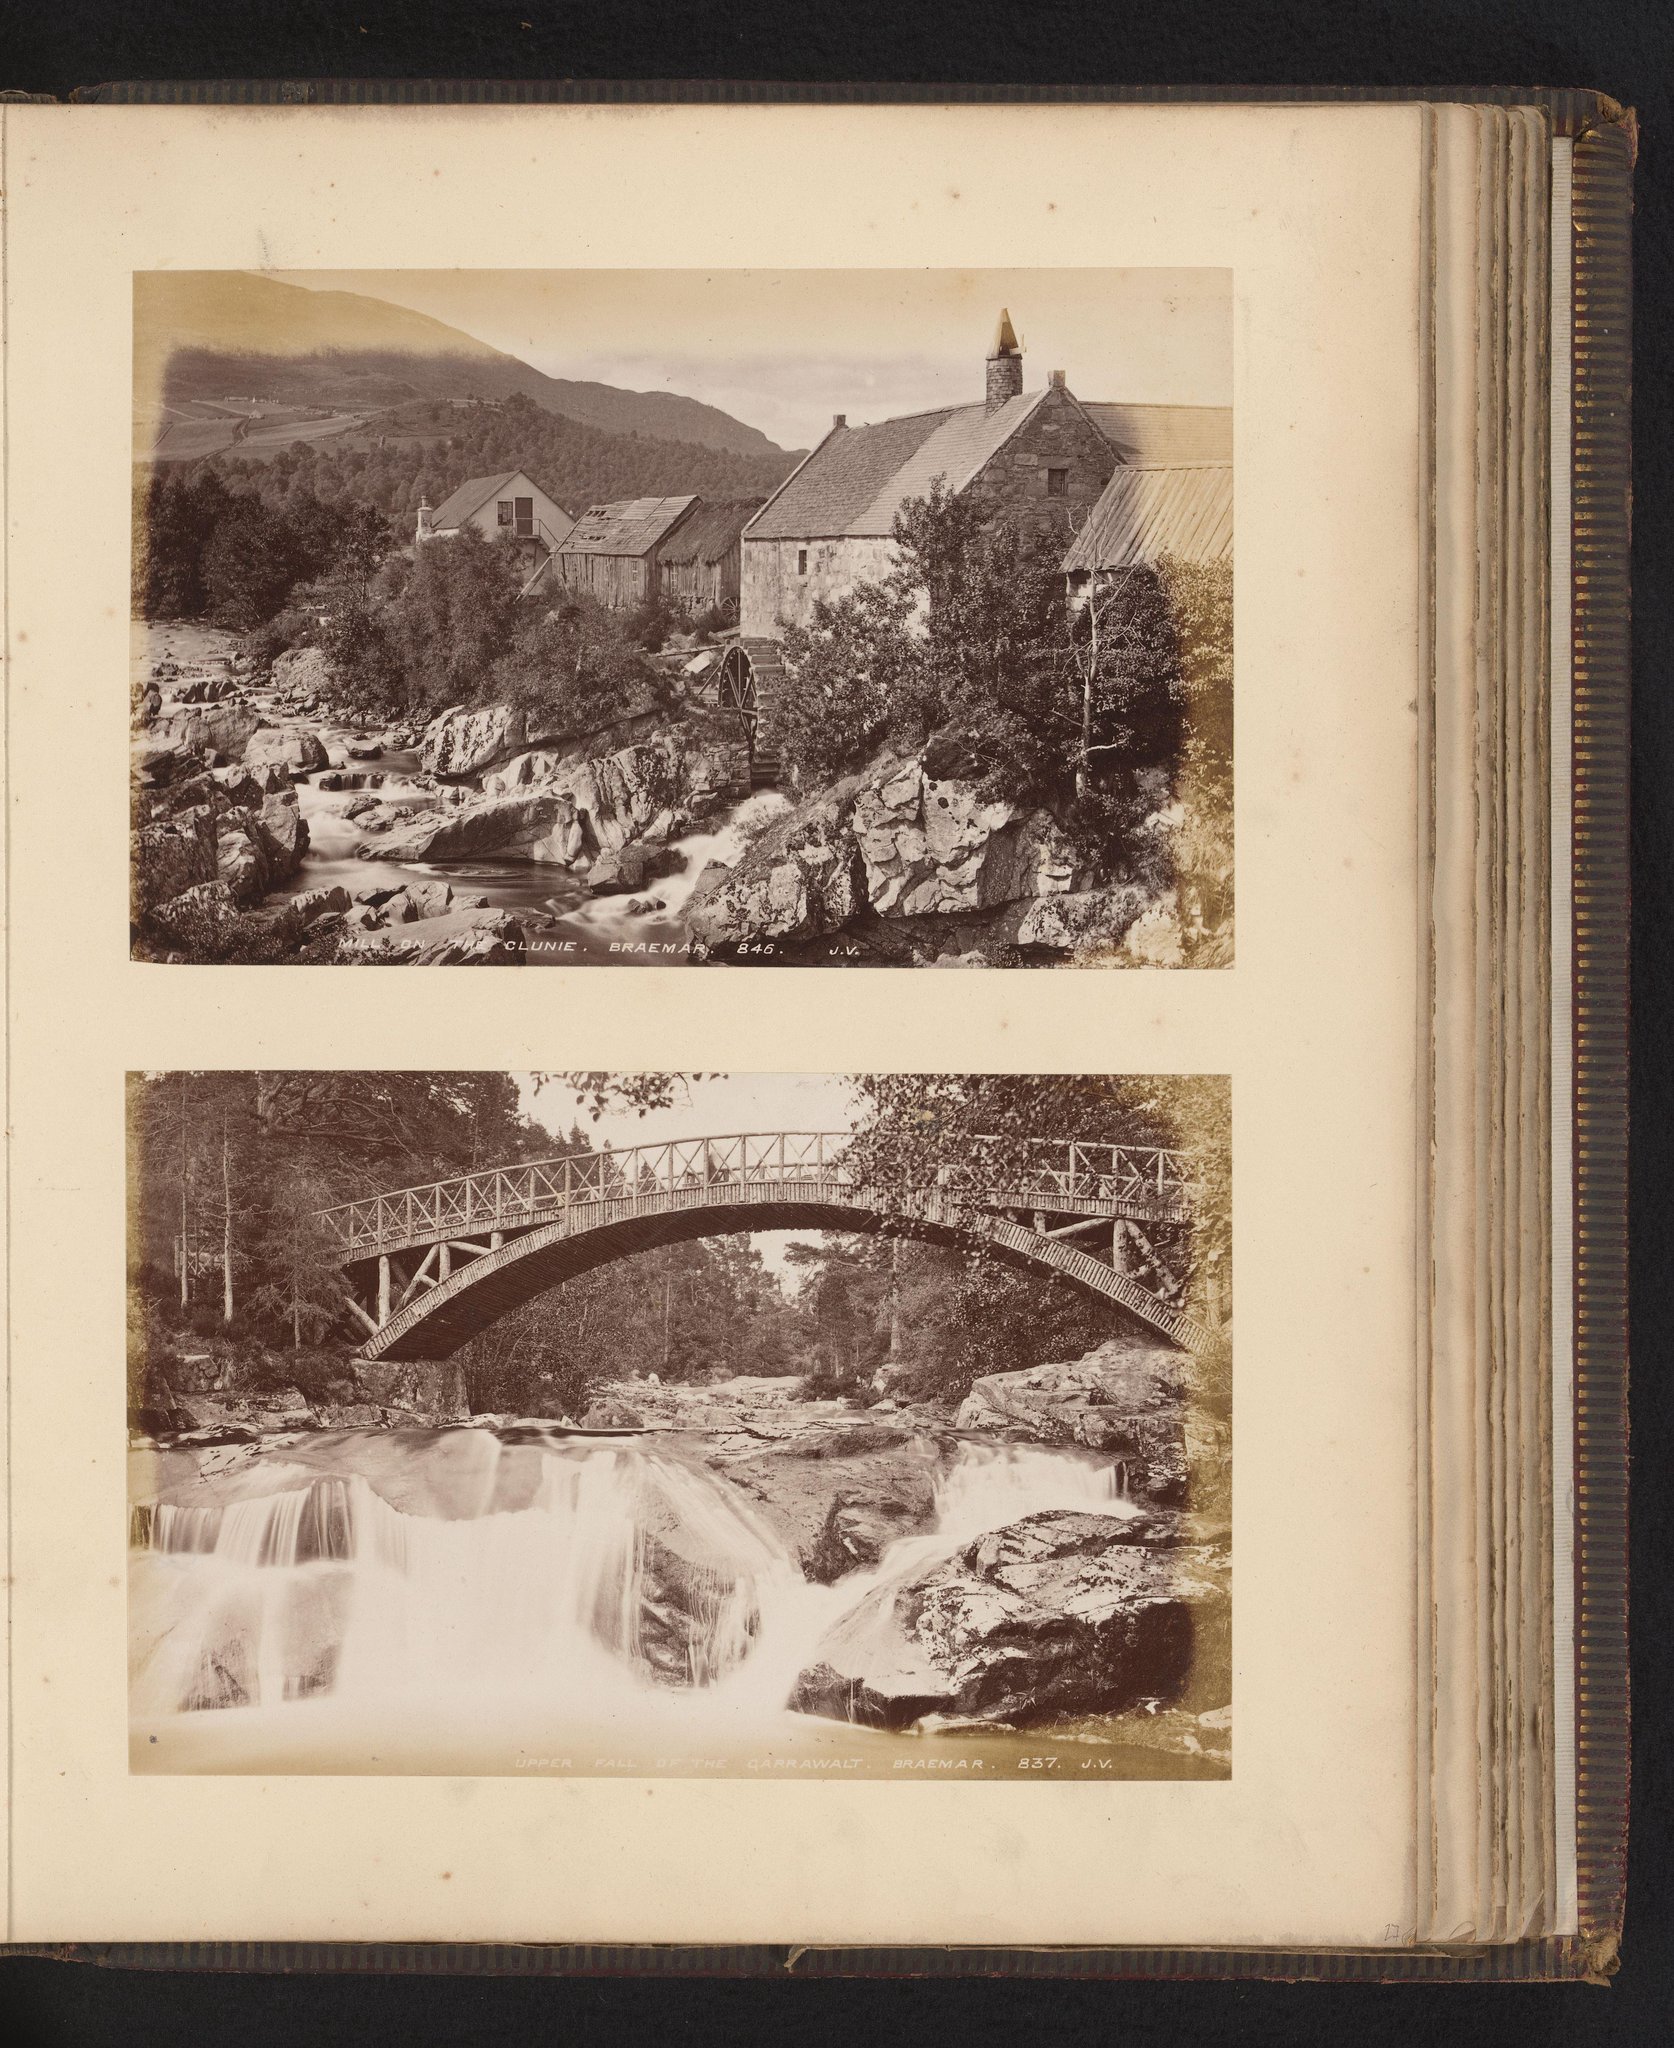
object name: photograph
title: Upper fall of the carrawalt, Braemar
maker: Anonymous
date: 1875-1885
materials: photographic support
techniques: albumen print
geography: braemar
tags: landscapes with waters, waterscapes, seascapes (in the temperate zone), watermill, bridge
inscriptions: number: ‘837, J.V.’, number: ‘846, J.V.’